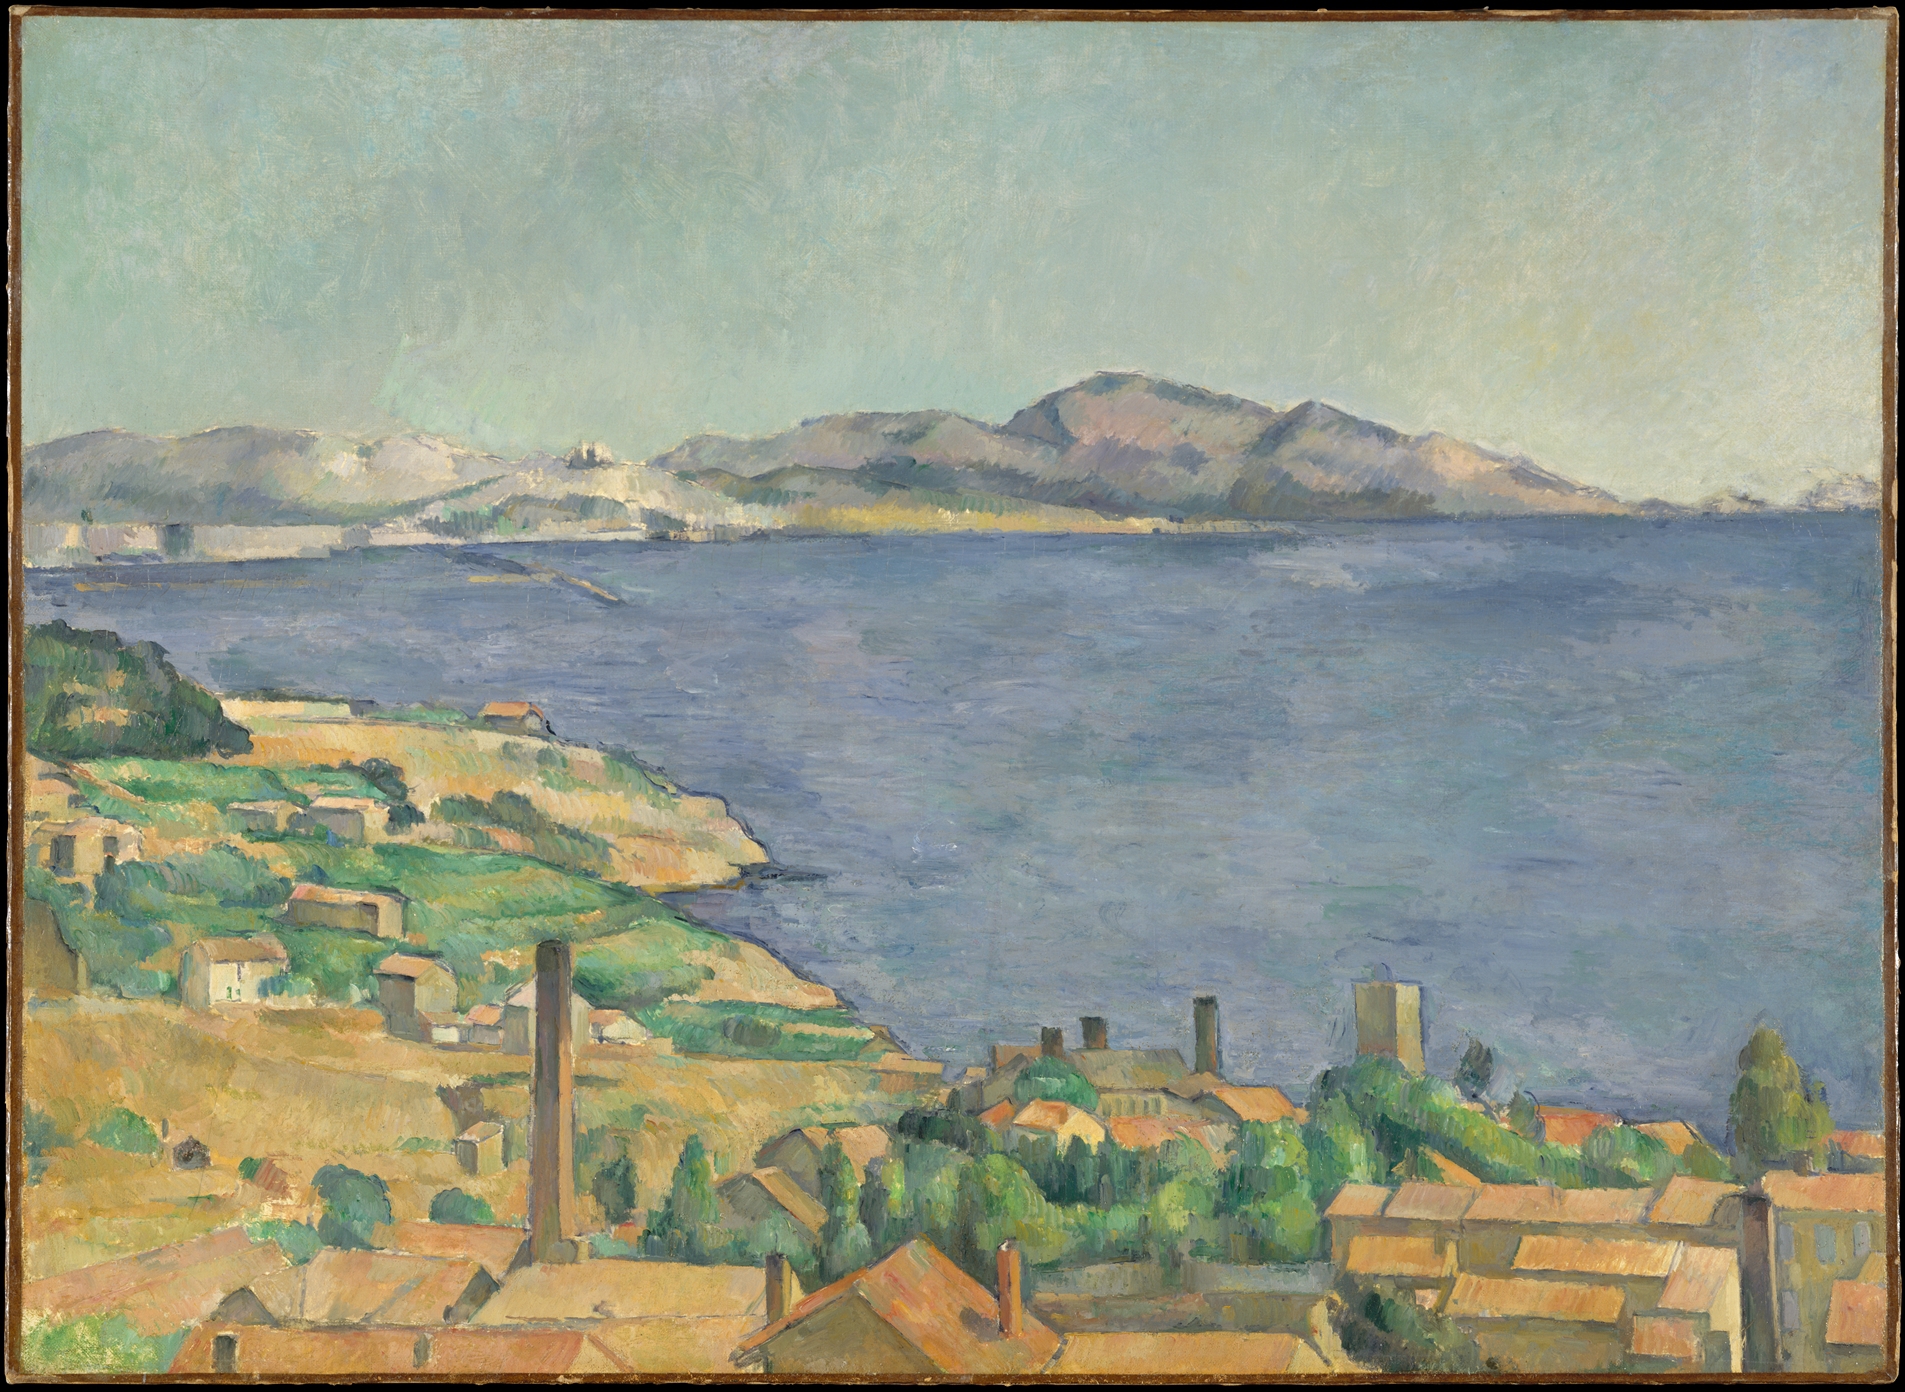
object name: painting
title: The Gulf of Marseille Seen from L'Estaque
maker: paul cézanne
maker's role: artist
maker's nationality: french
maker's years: 1839-1906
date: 1885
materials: canvas, oil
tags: towns,seas